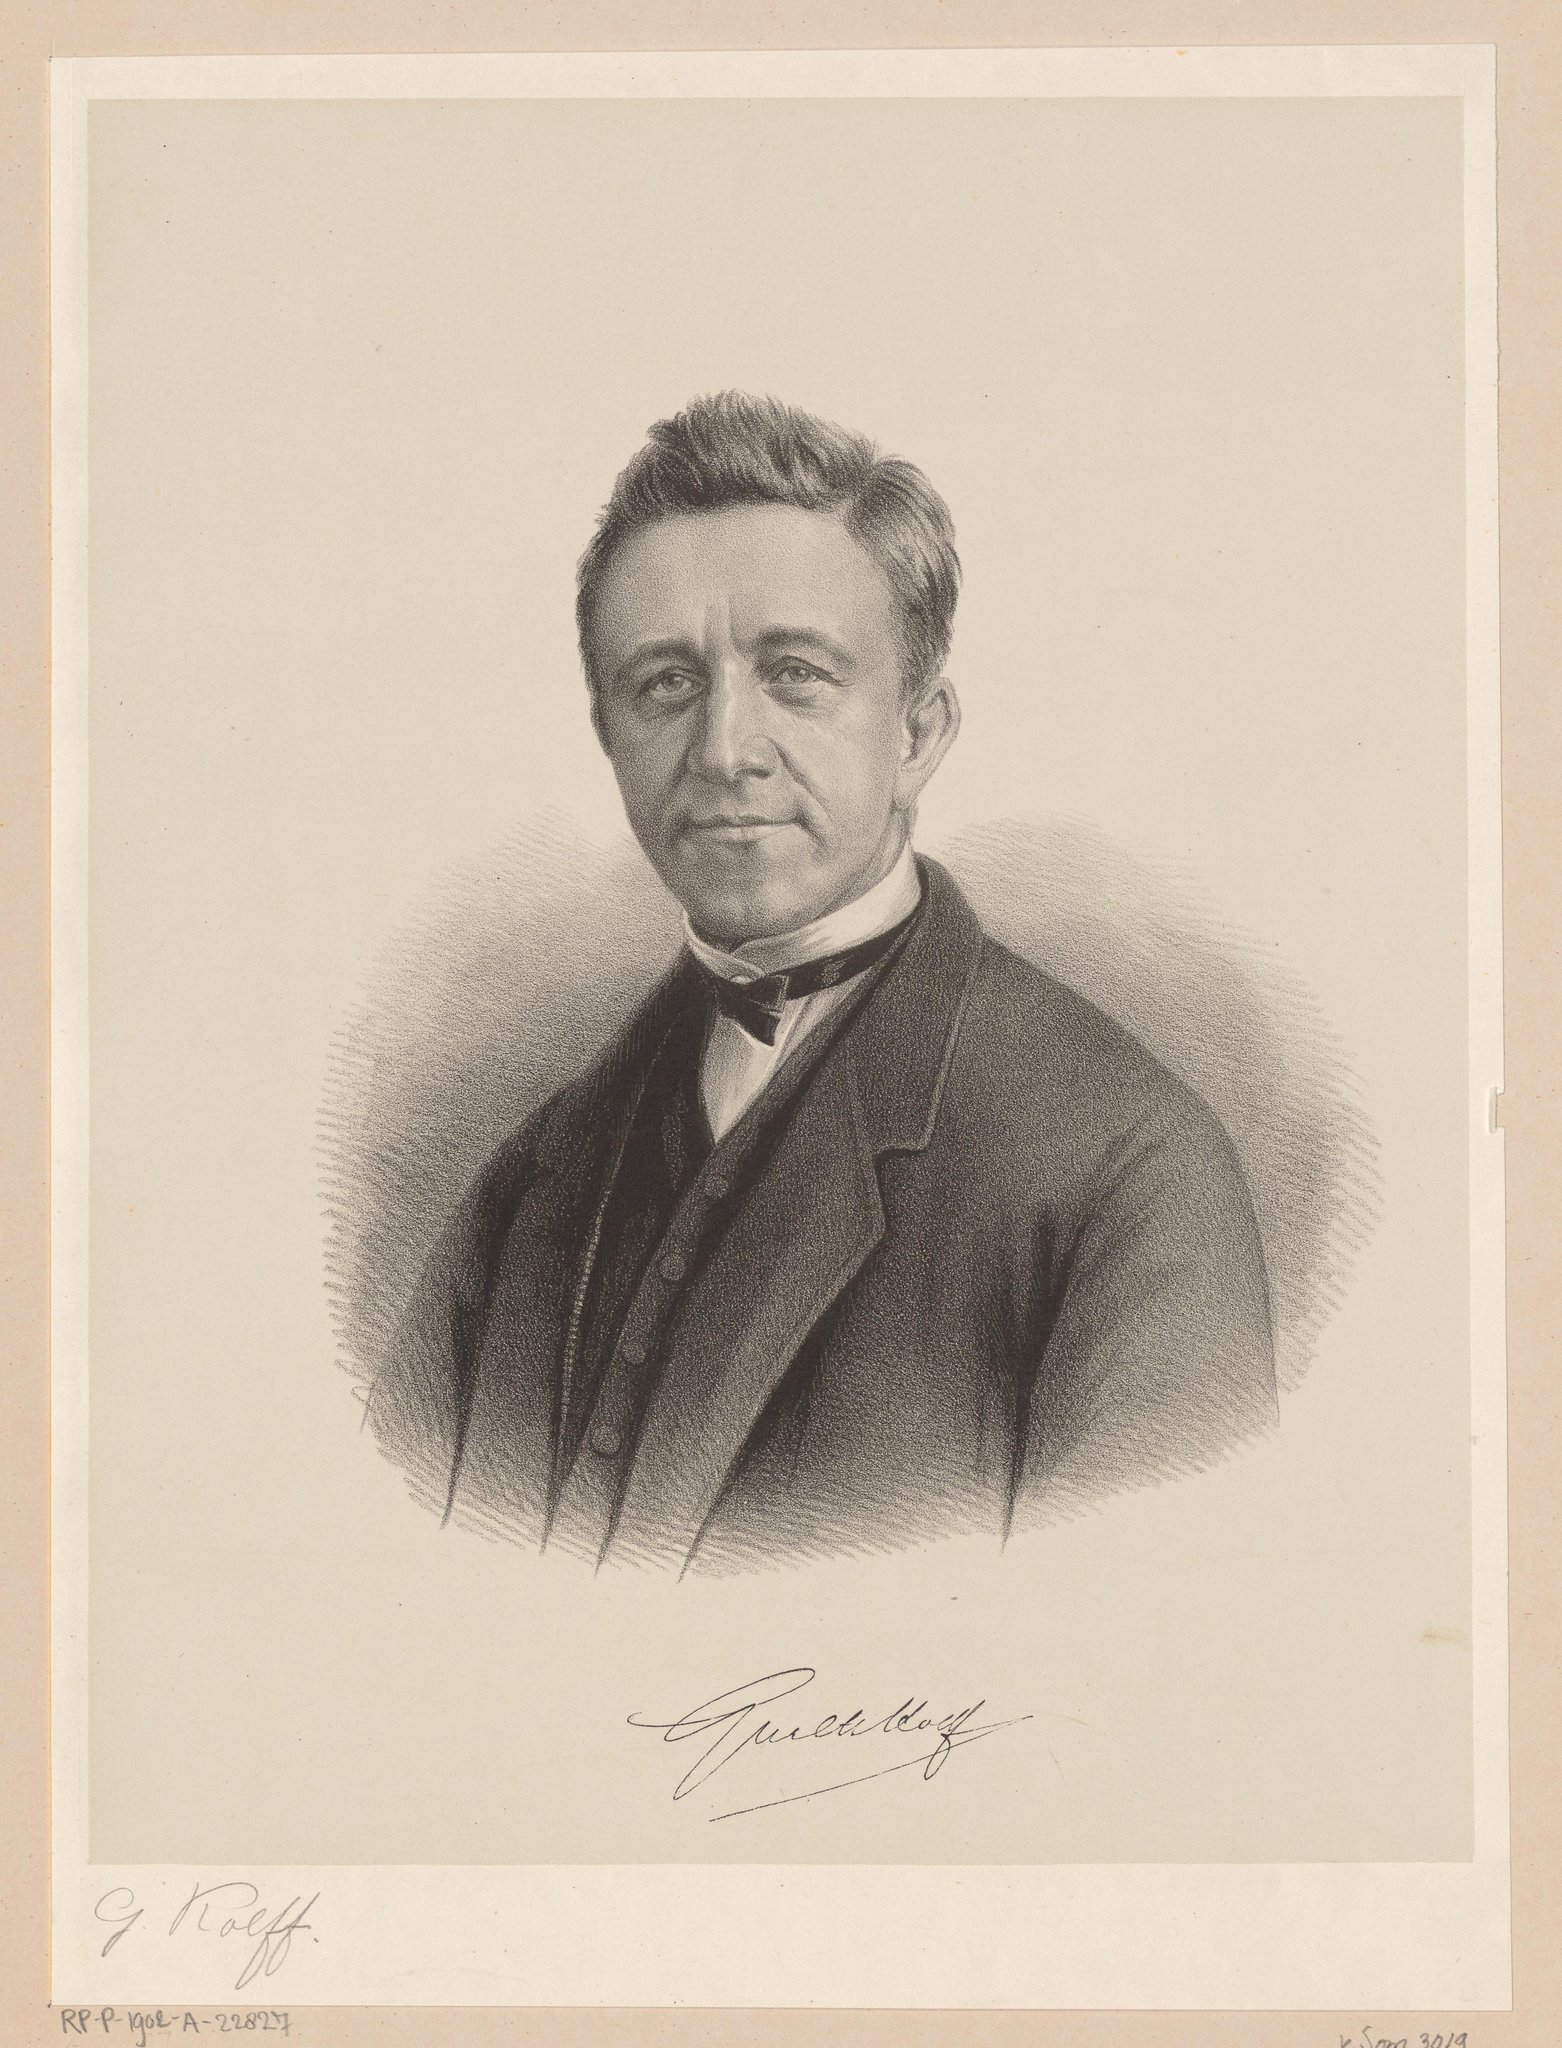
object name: print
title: Portret van Gualtherus Kolff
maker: Anonymous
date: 1876-1902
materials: paper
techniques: lithograph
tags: publisher, gualtherus kolff, historical persons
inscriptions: collector's mark: Lugt 2228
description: Onder het portret een facsimile van de handtekening van de geportretteerde.